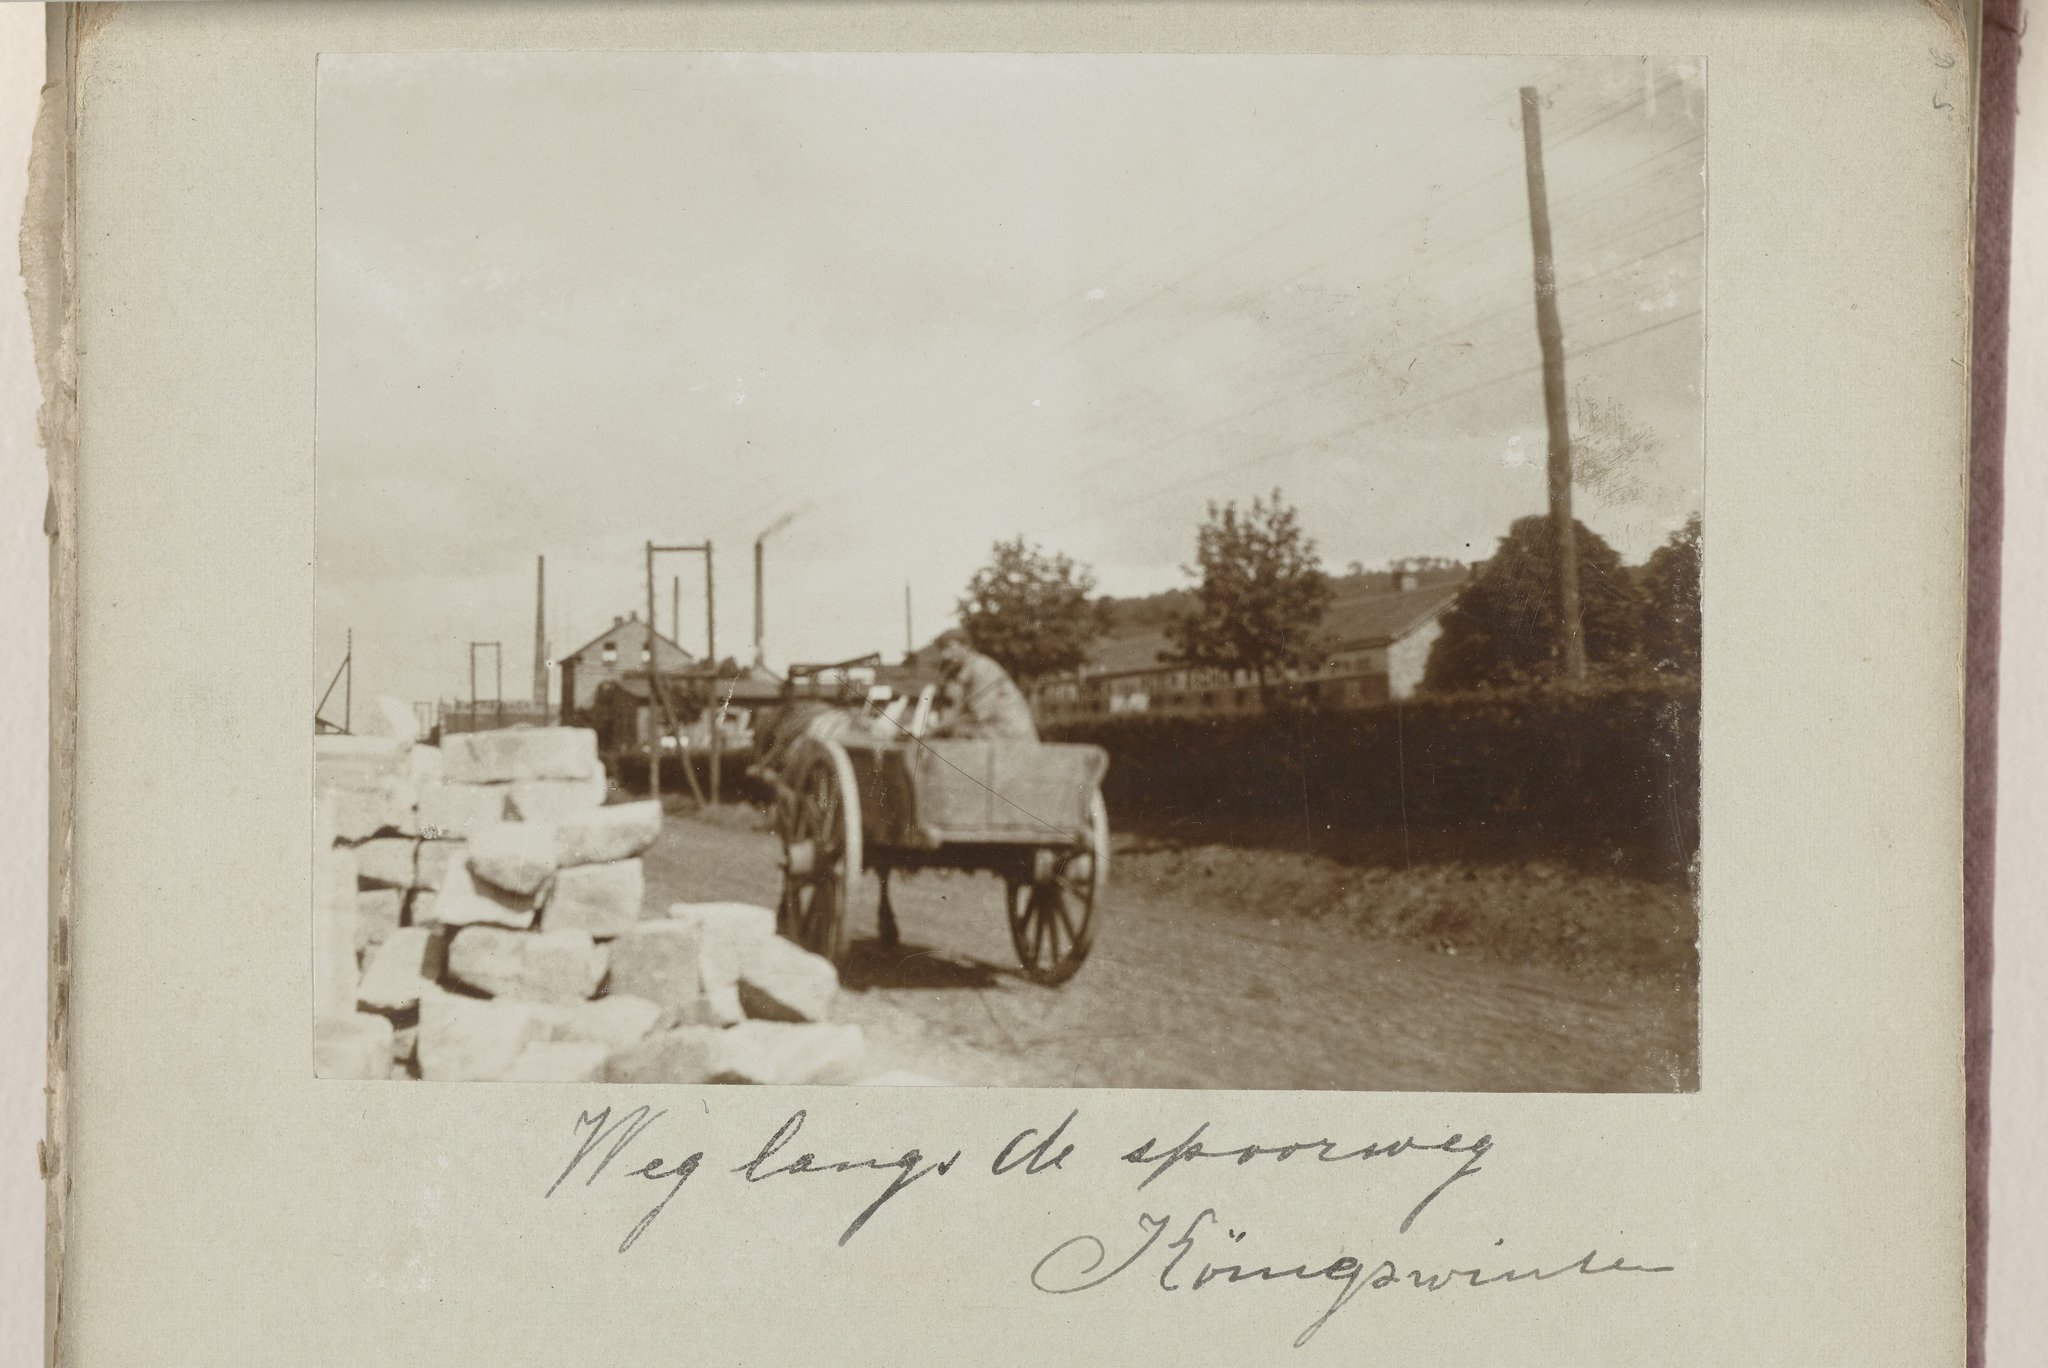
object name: photograph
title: Weg langs de spoorweg Königswinter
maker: david vermeulen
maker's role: fotograaf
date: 1895-1905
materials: paper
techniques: collodion silver print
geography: königswinter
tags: railway, tramway; rack railway, two-wheeled vehicle drawn by one animal